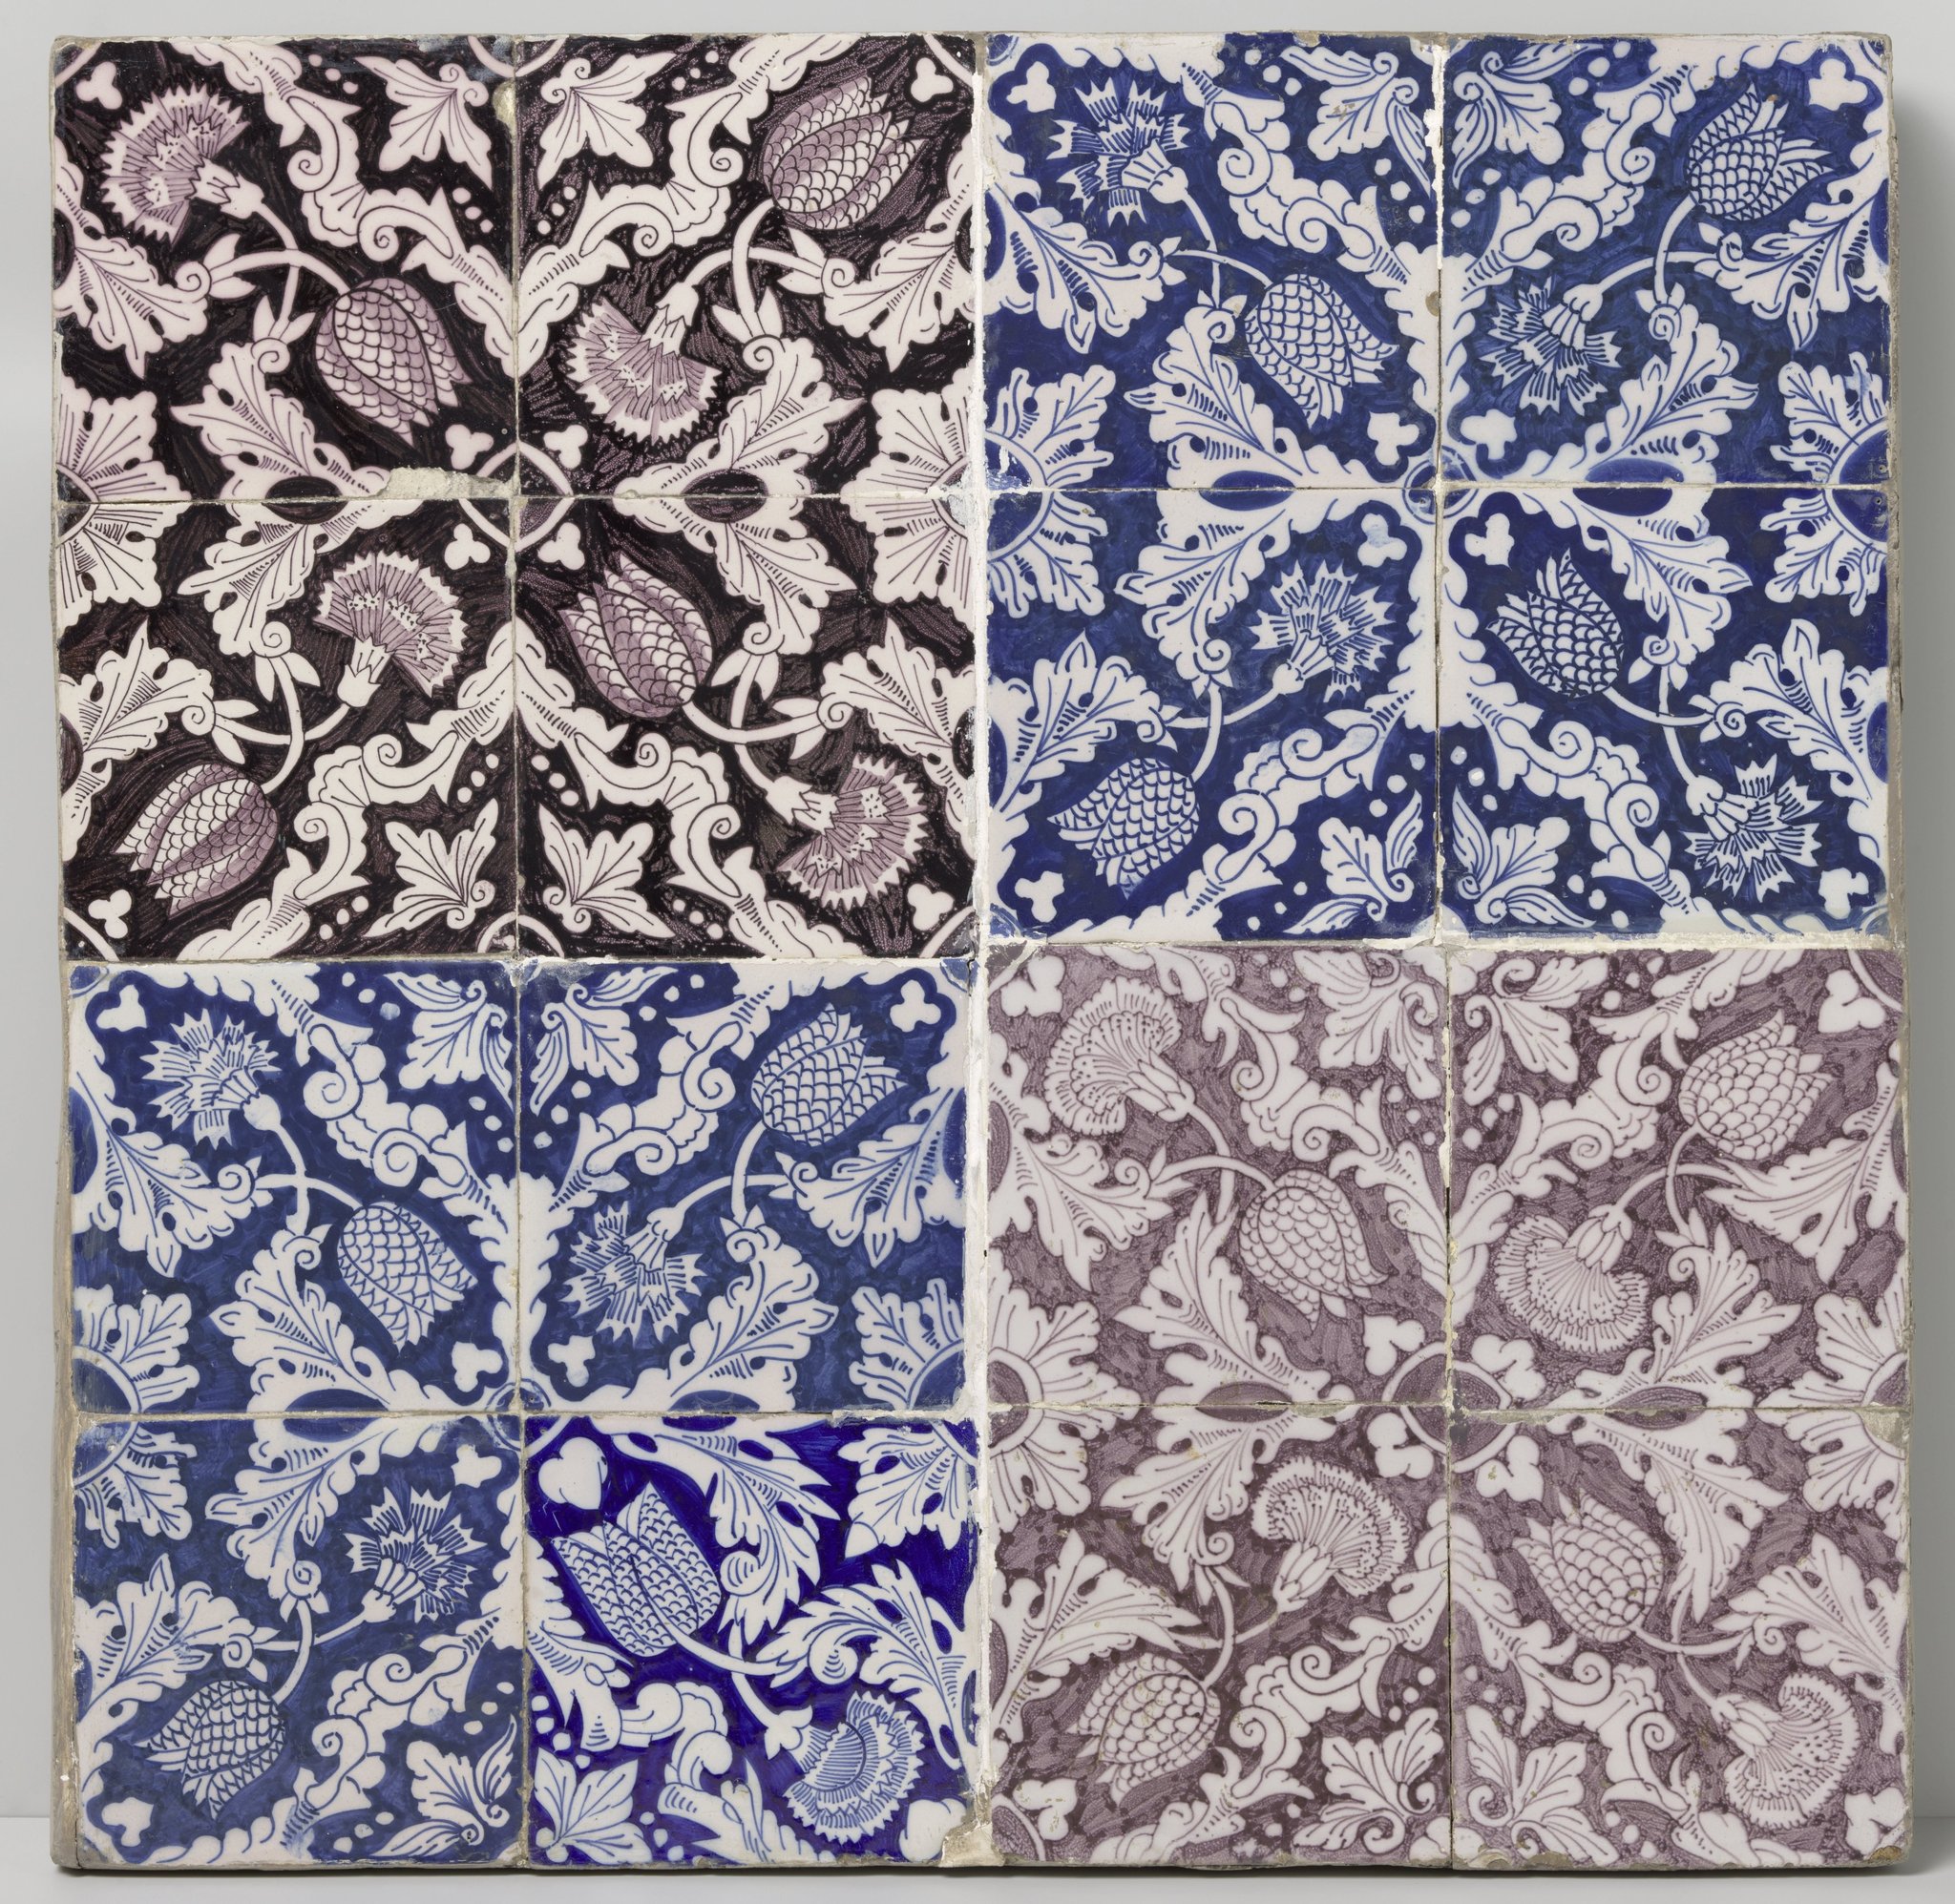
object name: tegelveld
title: Tegelveld van zestien tegels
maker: Anonymous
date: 1720-1780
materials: earthenware, glaze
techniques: maiolica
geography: netherlands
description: Tegelveld van 16 tegels (4 x 4) met een blauw of paars geschilderd ornament van anjers, tulpen of bladeren.